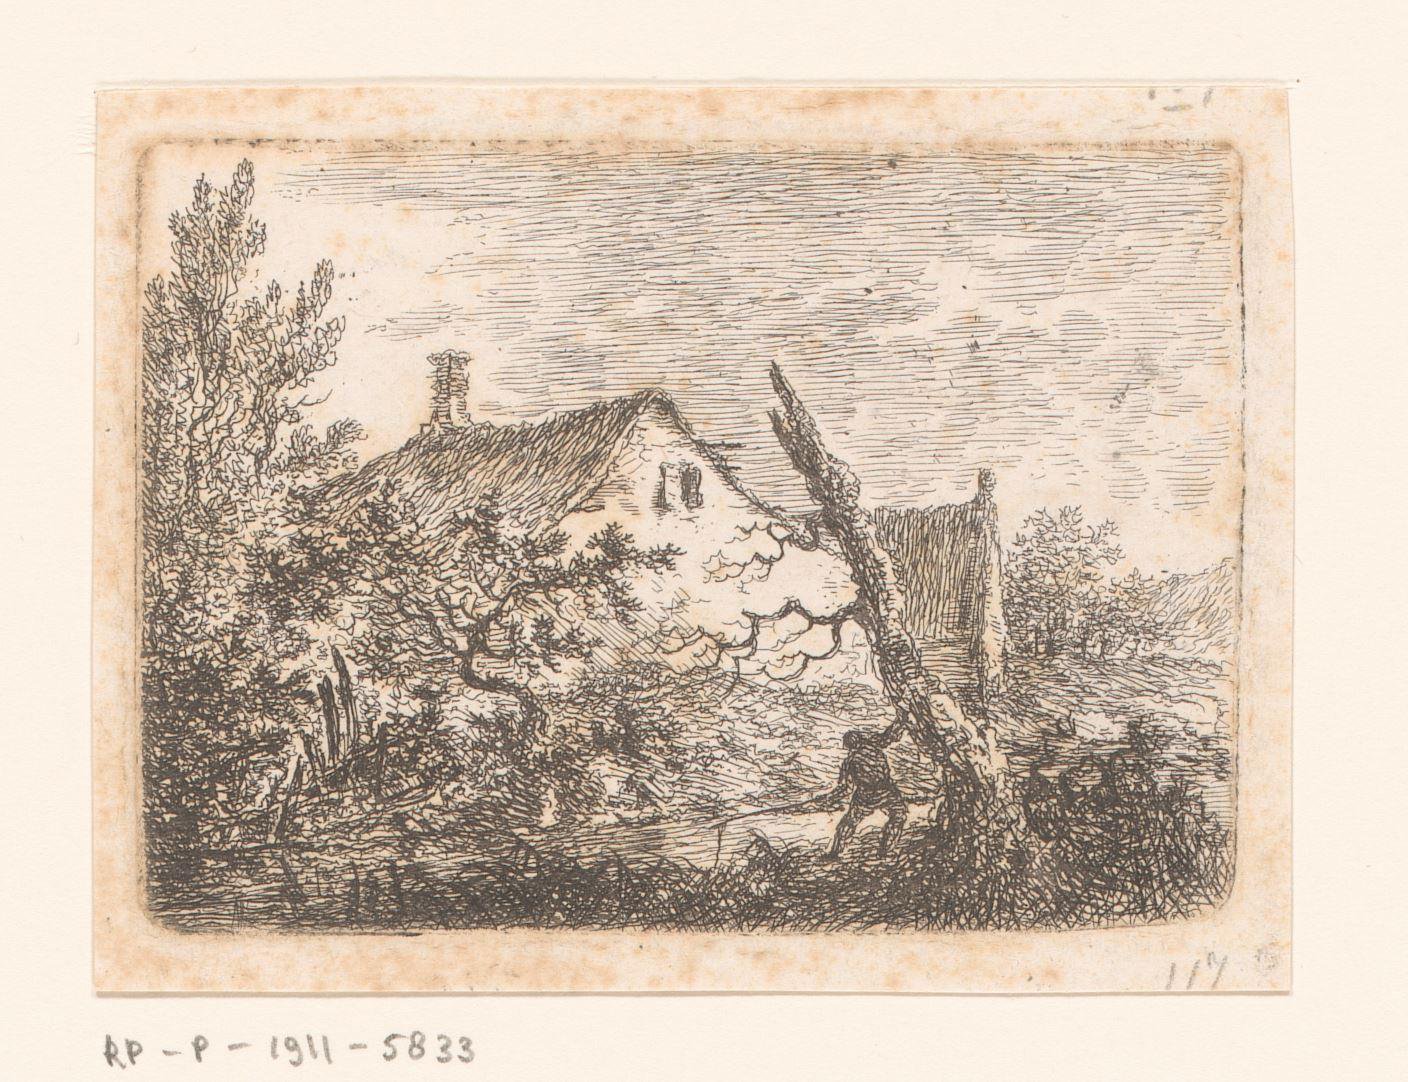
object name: print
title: Suite de douze petits sujets de païsage (...)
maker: sauveur legros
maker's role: print maker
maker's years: 1754-1834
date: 1796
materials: paper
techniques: etching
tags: cottage, fisherman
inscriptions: collector's mark: Lugt 2228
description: Maakt deel uit van een twaalfdelige serie met landschappen door Legros.